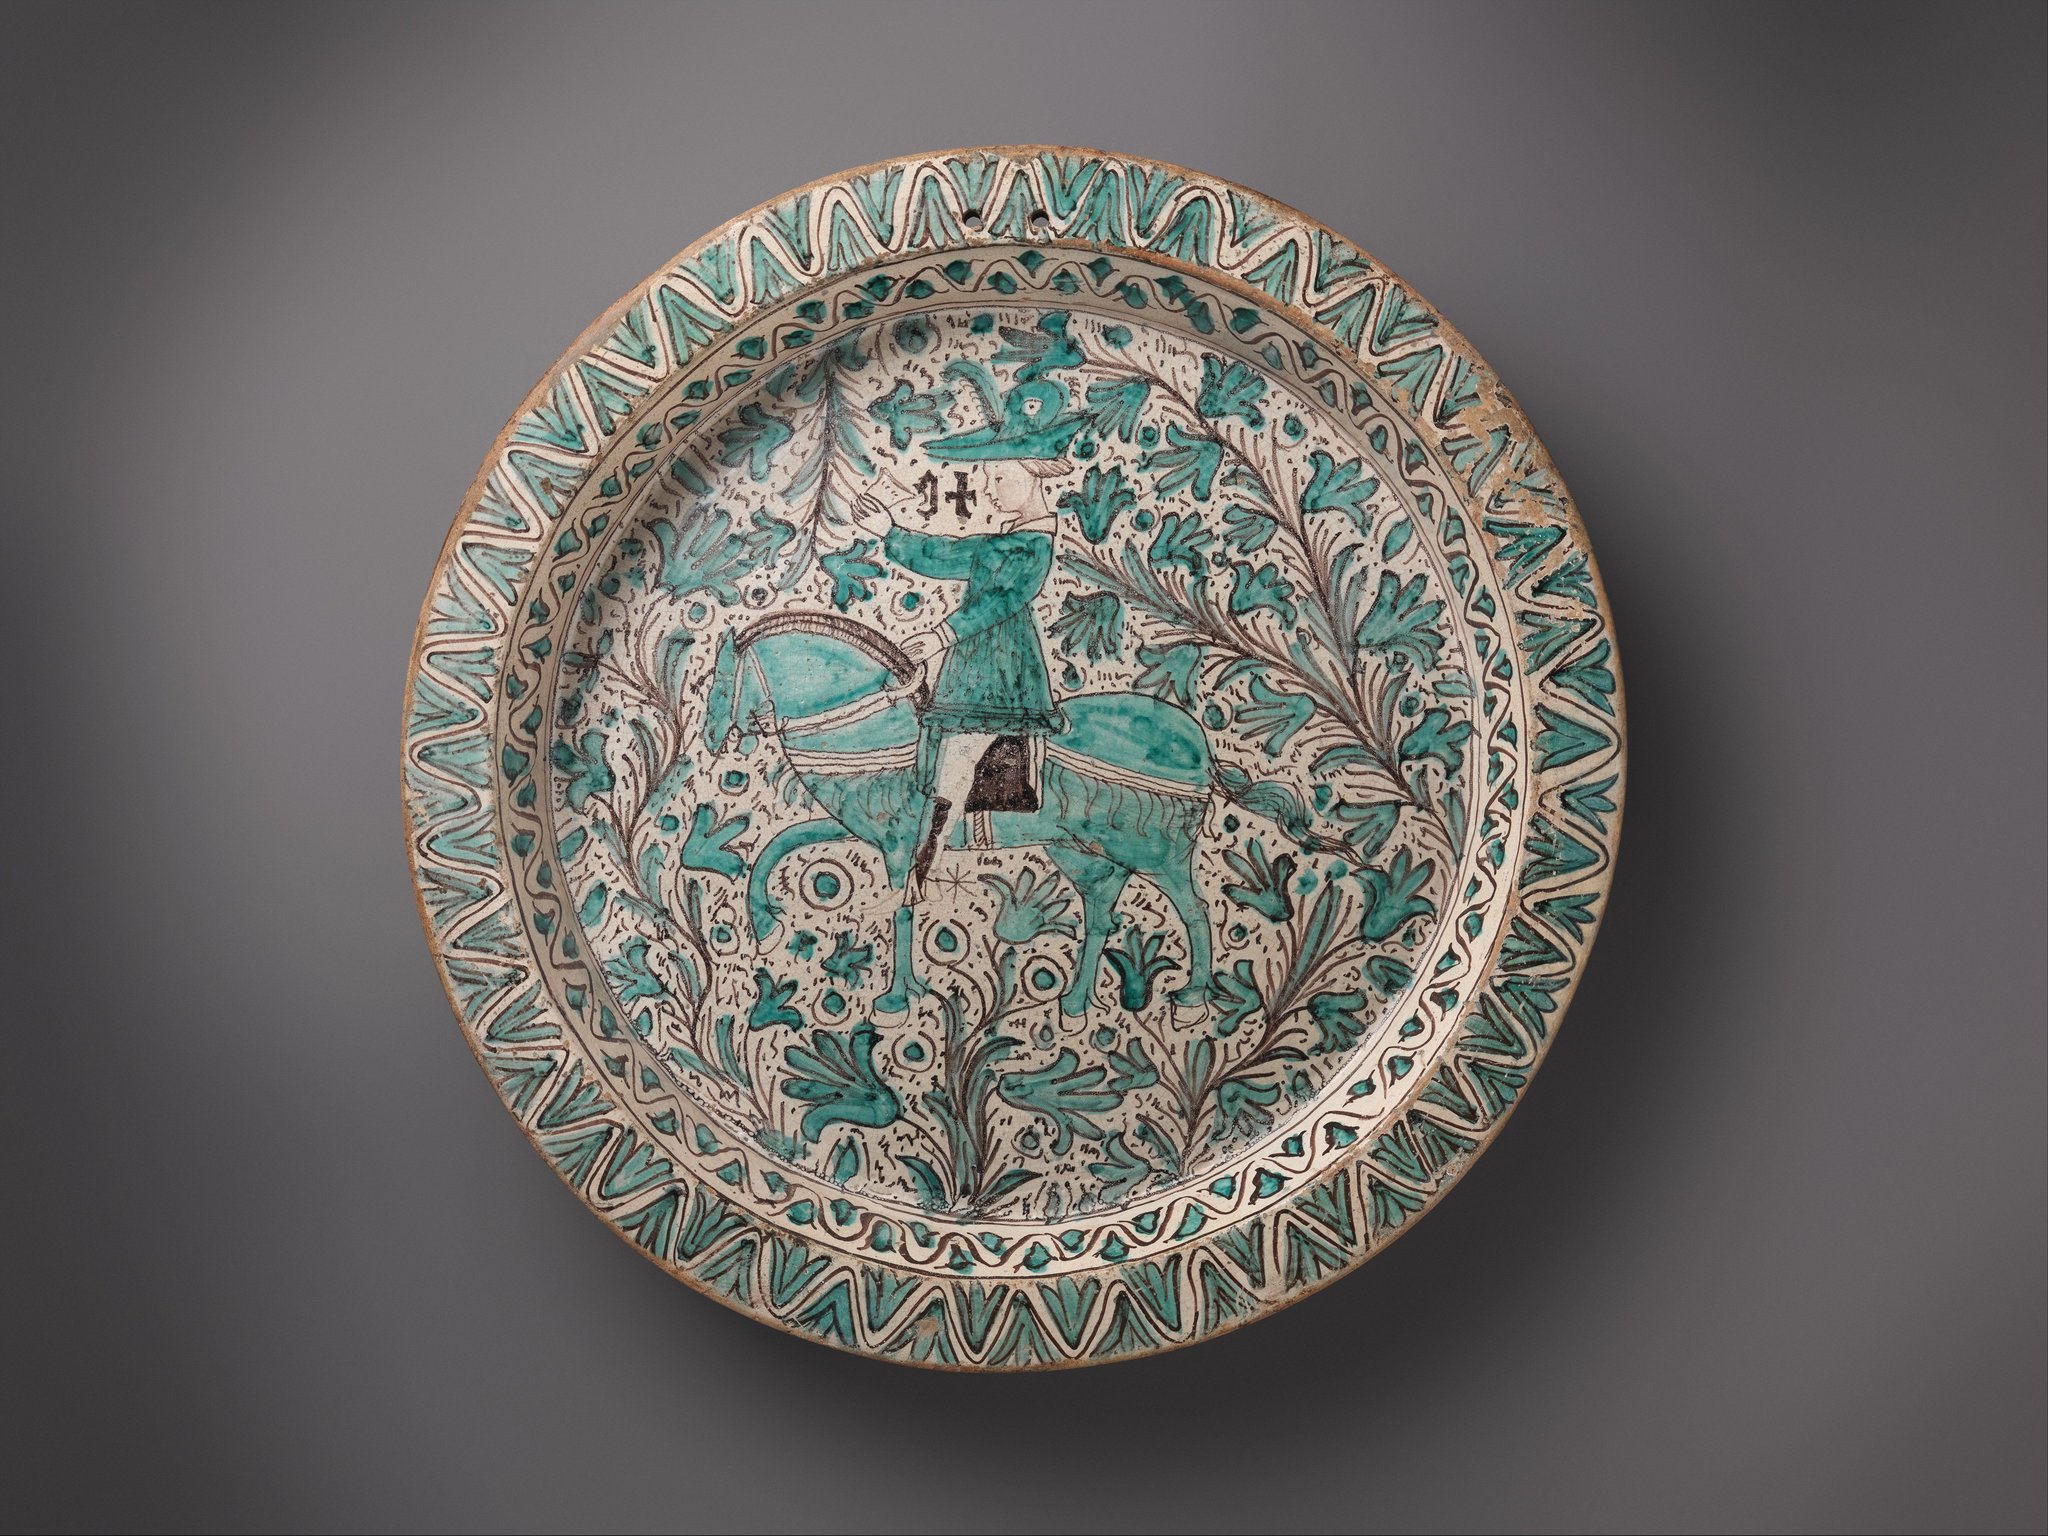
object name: dish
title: Large Dish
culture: italian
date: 1420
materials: earthenware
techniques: glazing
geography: italy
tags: men